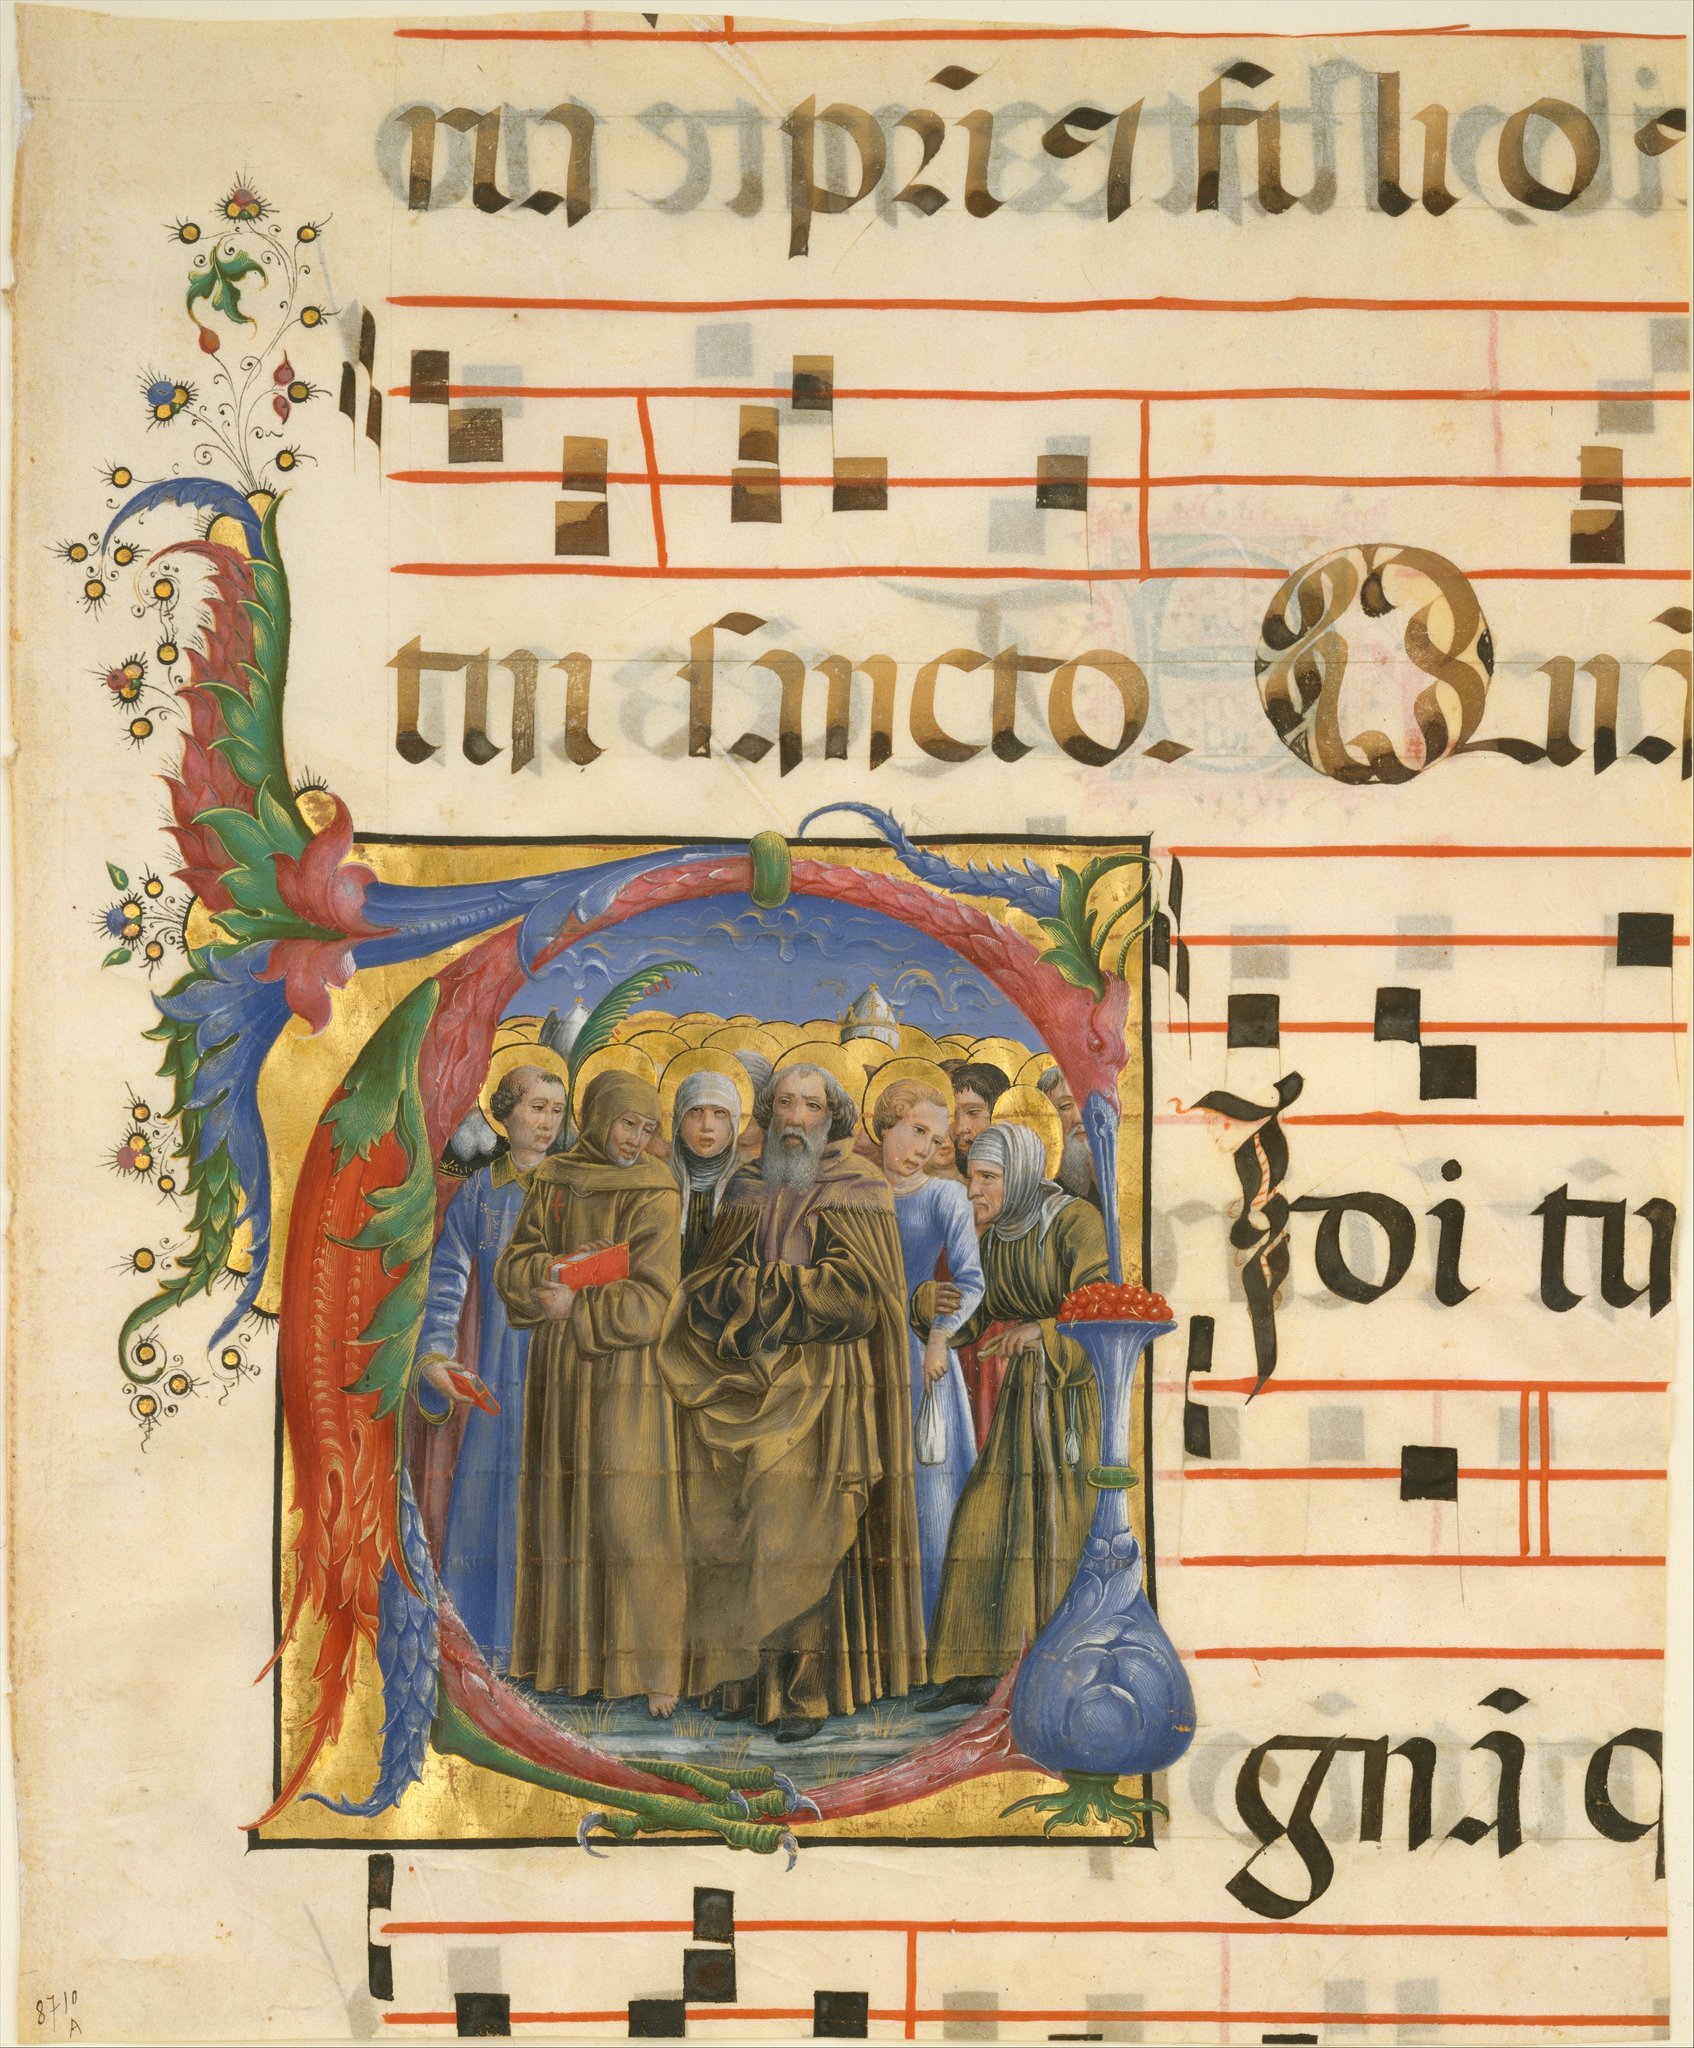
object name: antiphonary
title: Manuscript Illumination with All Saints in an Initial V, from an Antiphonary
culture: italian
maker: cosmè tura (cosimo di domenico di bonaventura)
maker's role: artist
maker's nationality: italian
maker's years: 1433-1495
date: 1450-1460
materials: gold, ink, parchment, paint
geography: italy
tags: saints